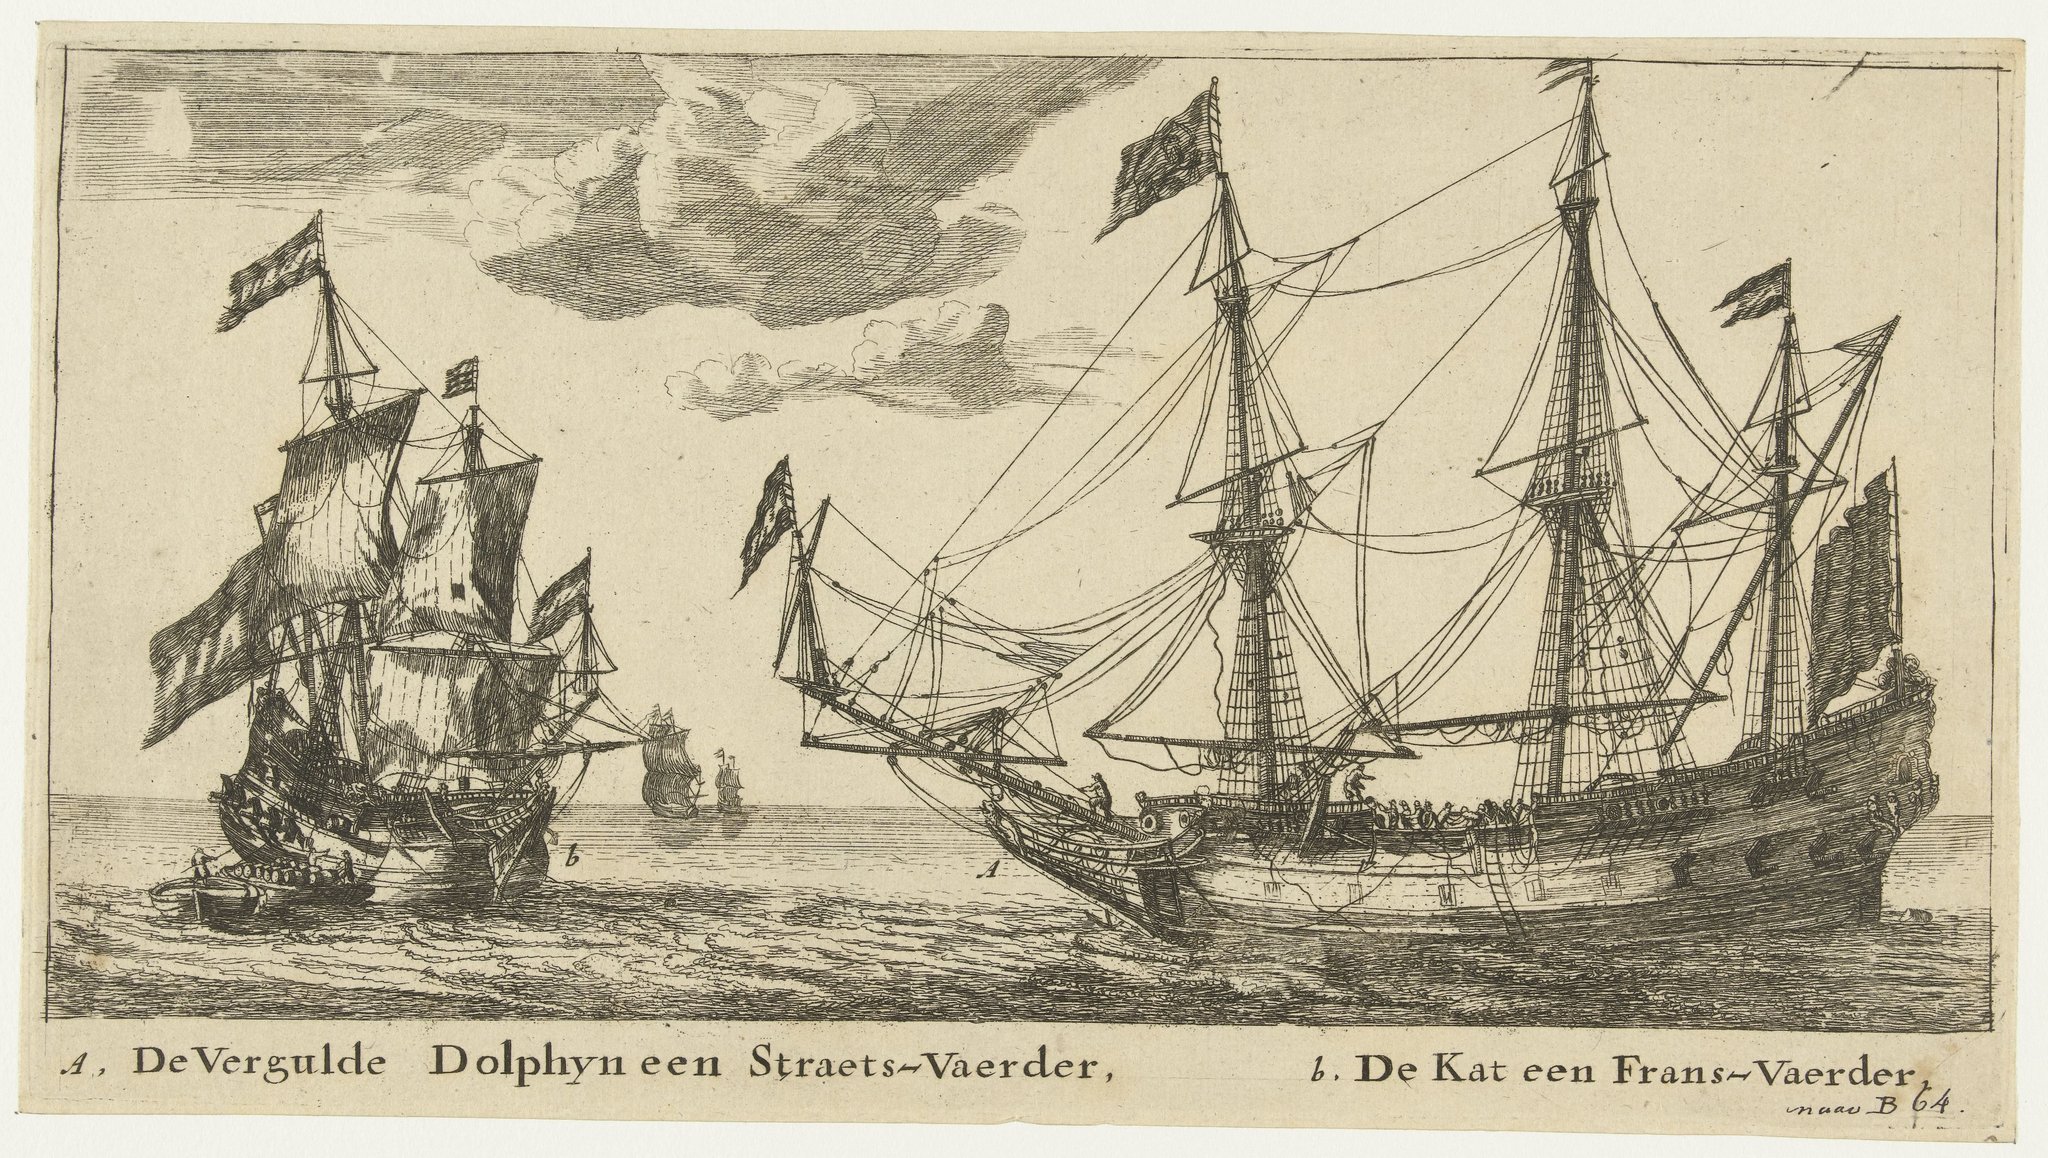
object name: print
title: De Vergulde Dolphyn een Straets-Vaerder, De Kat een Frans-Vaerder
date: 1652-1701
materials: paper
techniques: etching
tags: sailing-ship, sailing-boat (with name), sailing-ship, sailing-boat (catship)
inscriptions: inscription: ‘naar B 64’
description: Kopie in spiegelbeeld. De Vergulde Dolphijn, een groot koopvaardijschip varend op de Straat van Gibraltar, en De Kat, een koopvaardijschip varend op Frankrijk.